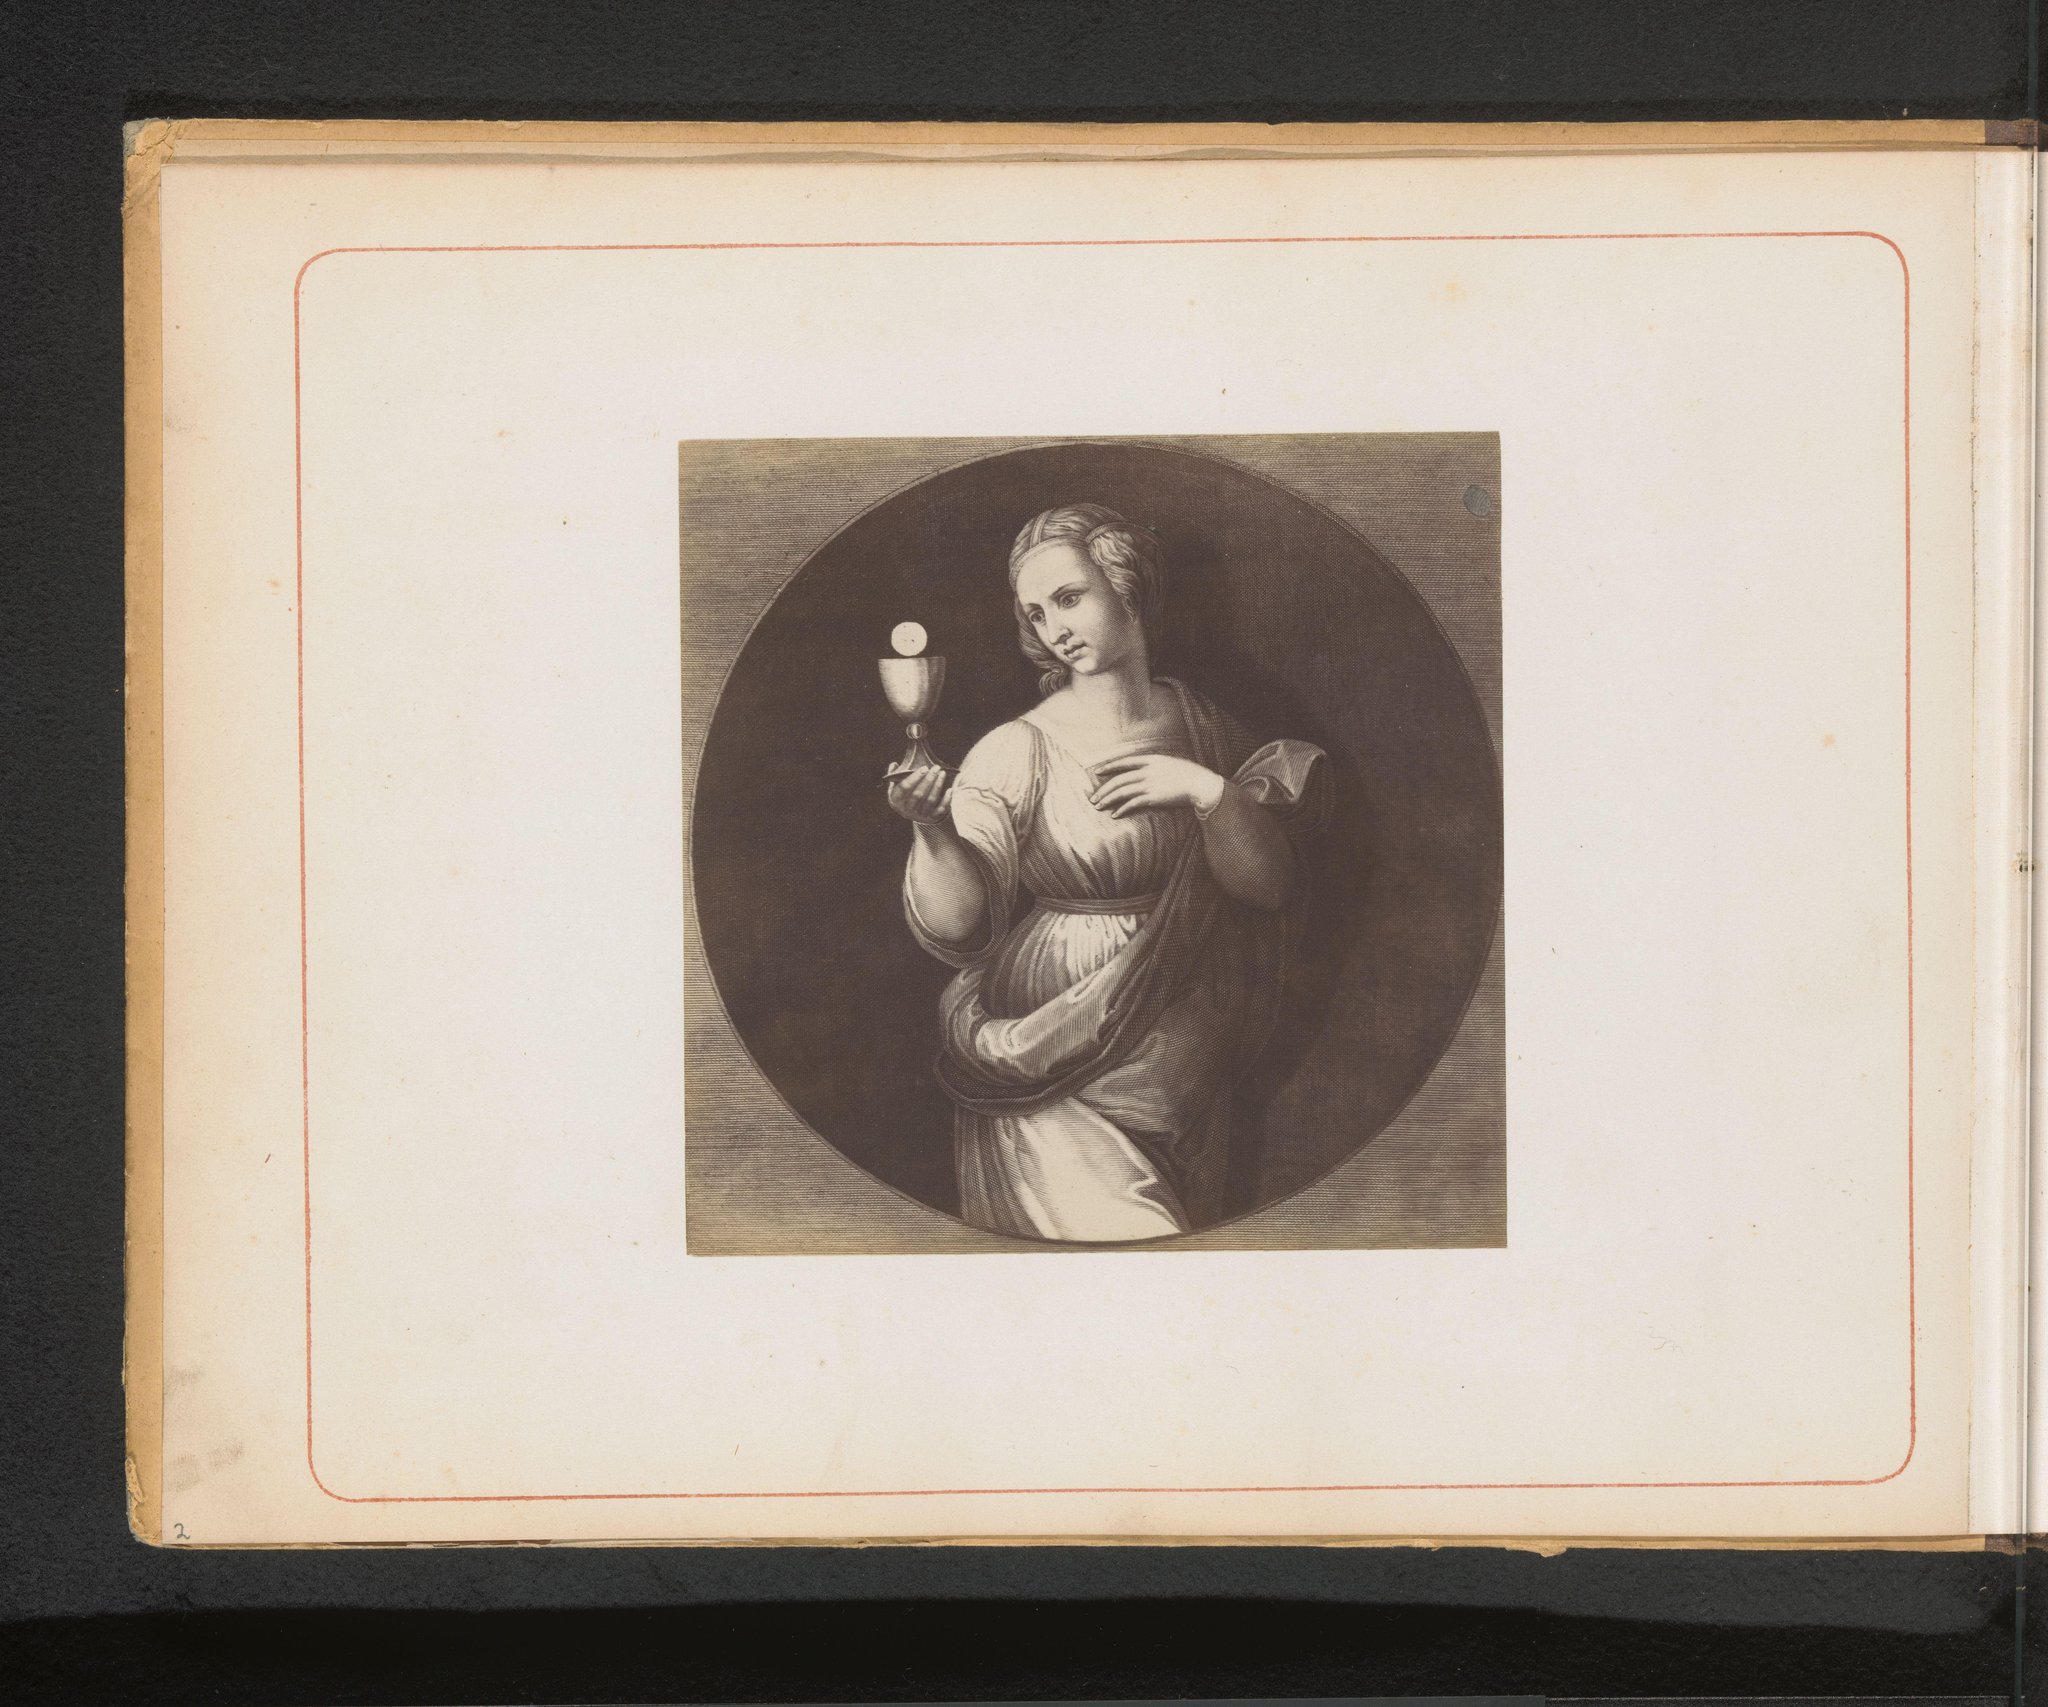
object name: reproduction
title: Fotoreproductie van een gravure naar Geloof door Rafaël in het Vaticaan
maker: Anonymous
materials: photographic support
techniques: albumen print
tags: faith, 'fides'; 'fede', 'fede catholica', 'fede christiana', 'fede christiana catholica' (ripa) ~ one of the three theological virtues